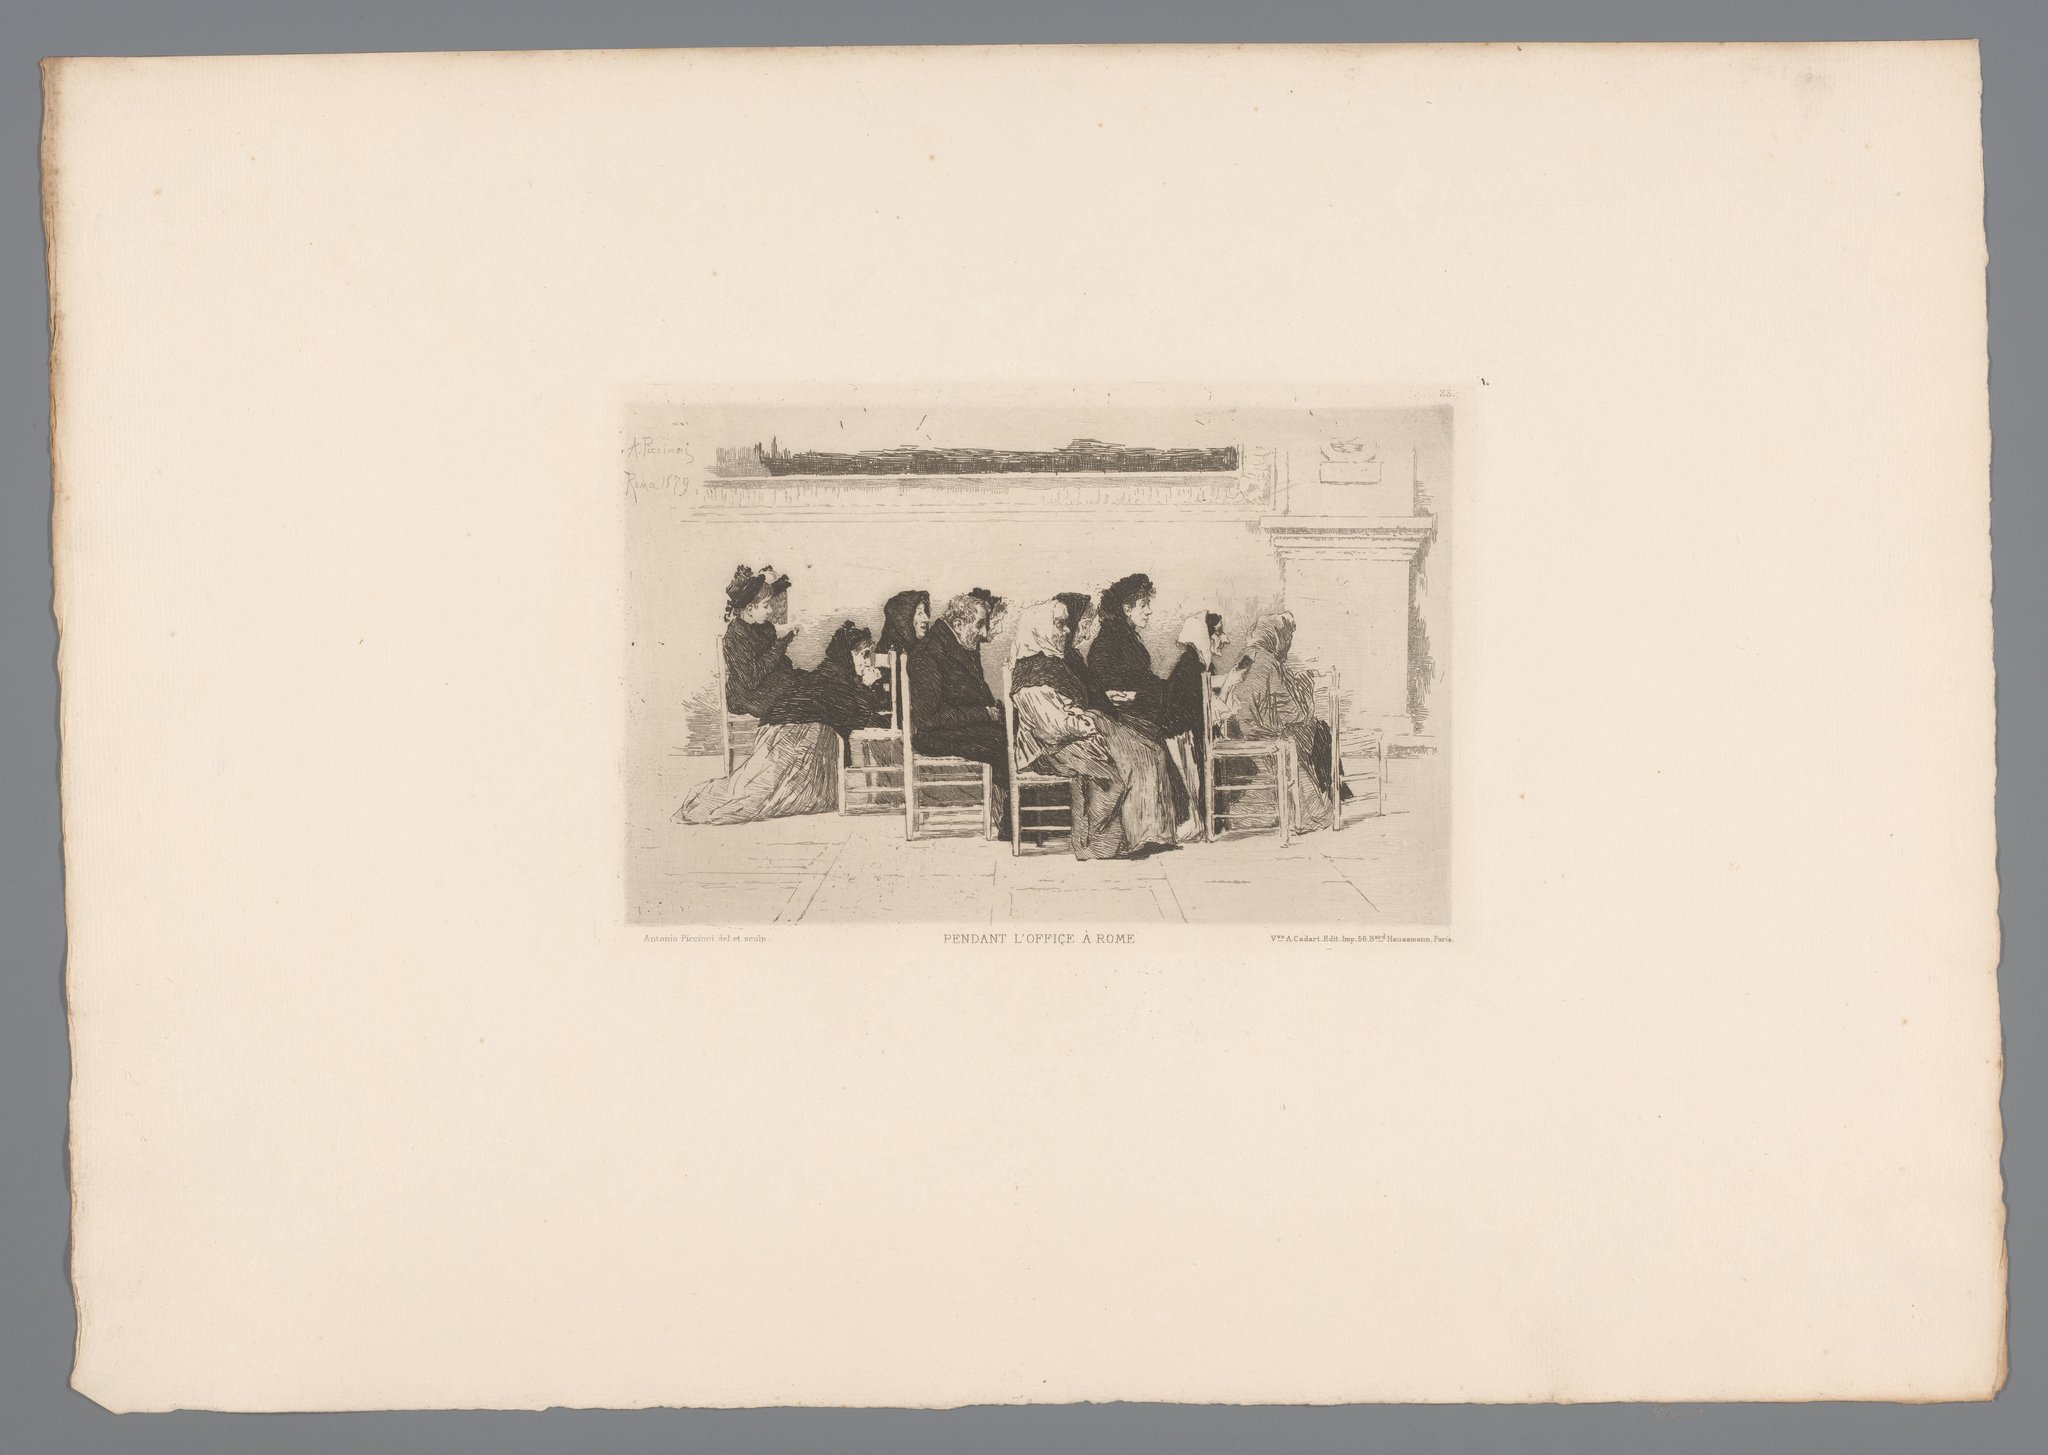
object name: print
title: Pendant l'office à Rome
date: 1880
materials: paper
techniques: drypoint, etching, intaglio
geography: paris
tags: holy mass (divine service, especially of roman catholic church)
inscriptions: collector's mark: Lugt 2228, collector's mark: ‘AFE v S’, watermark, collector's mark: Lugt 2760